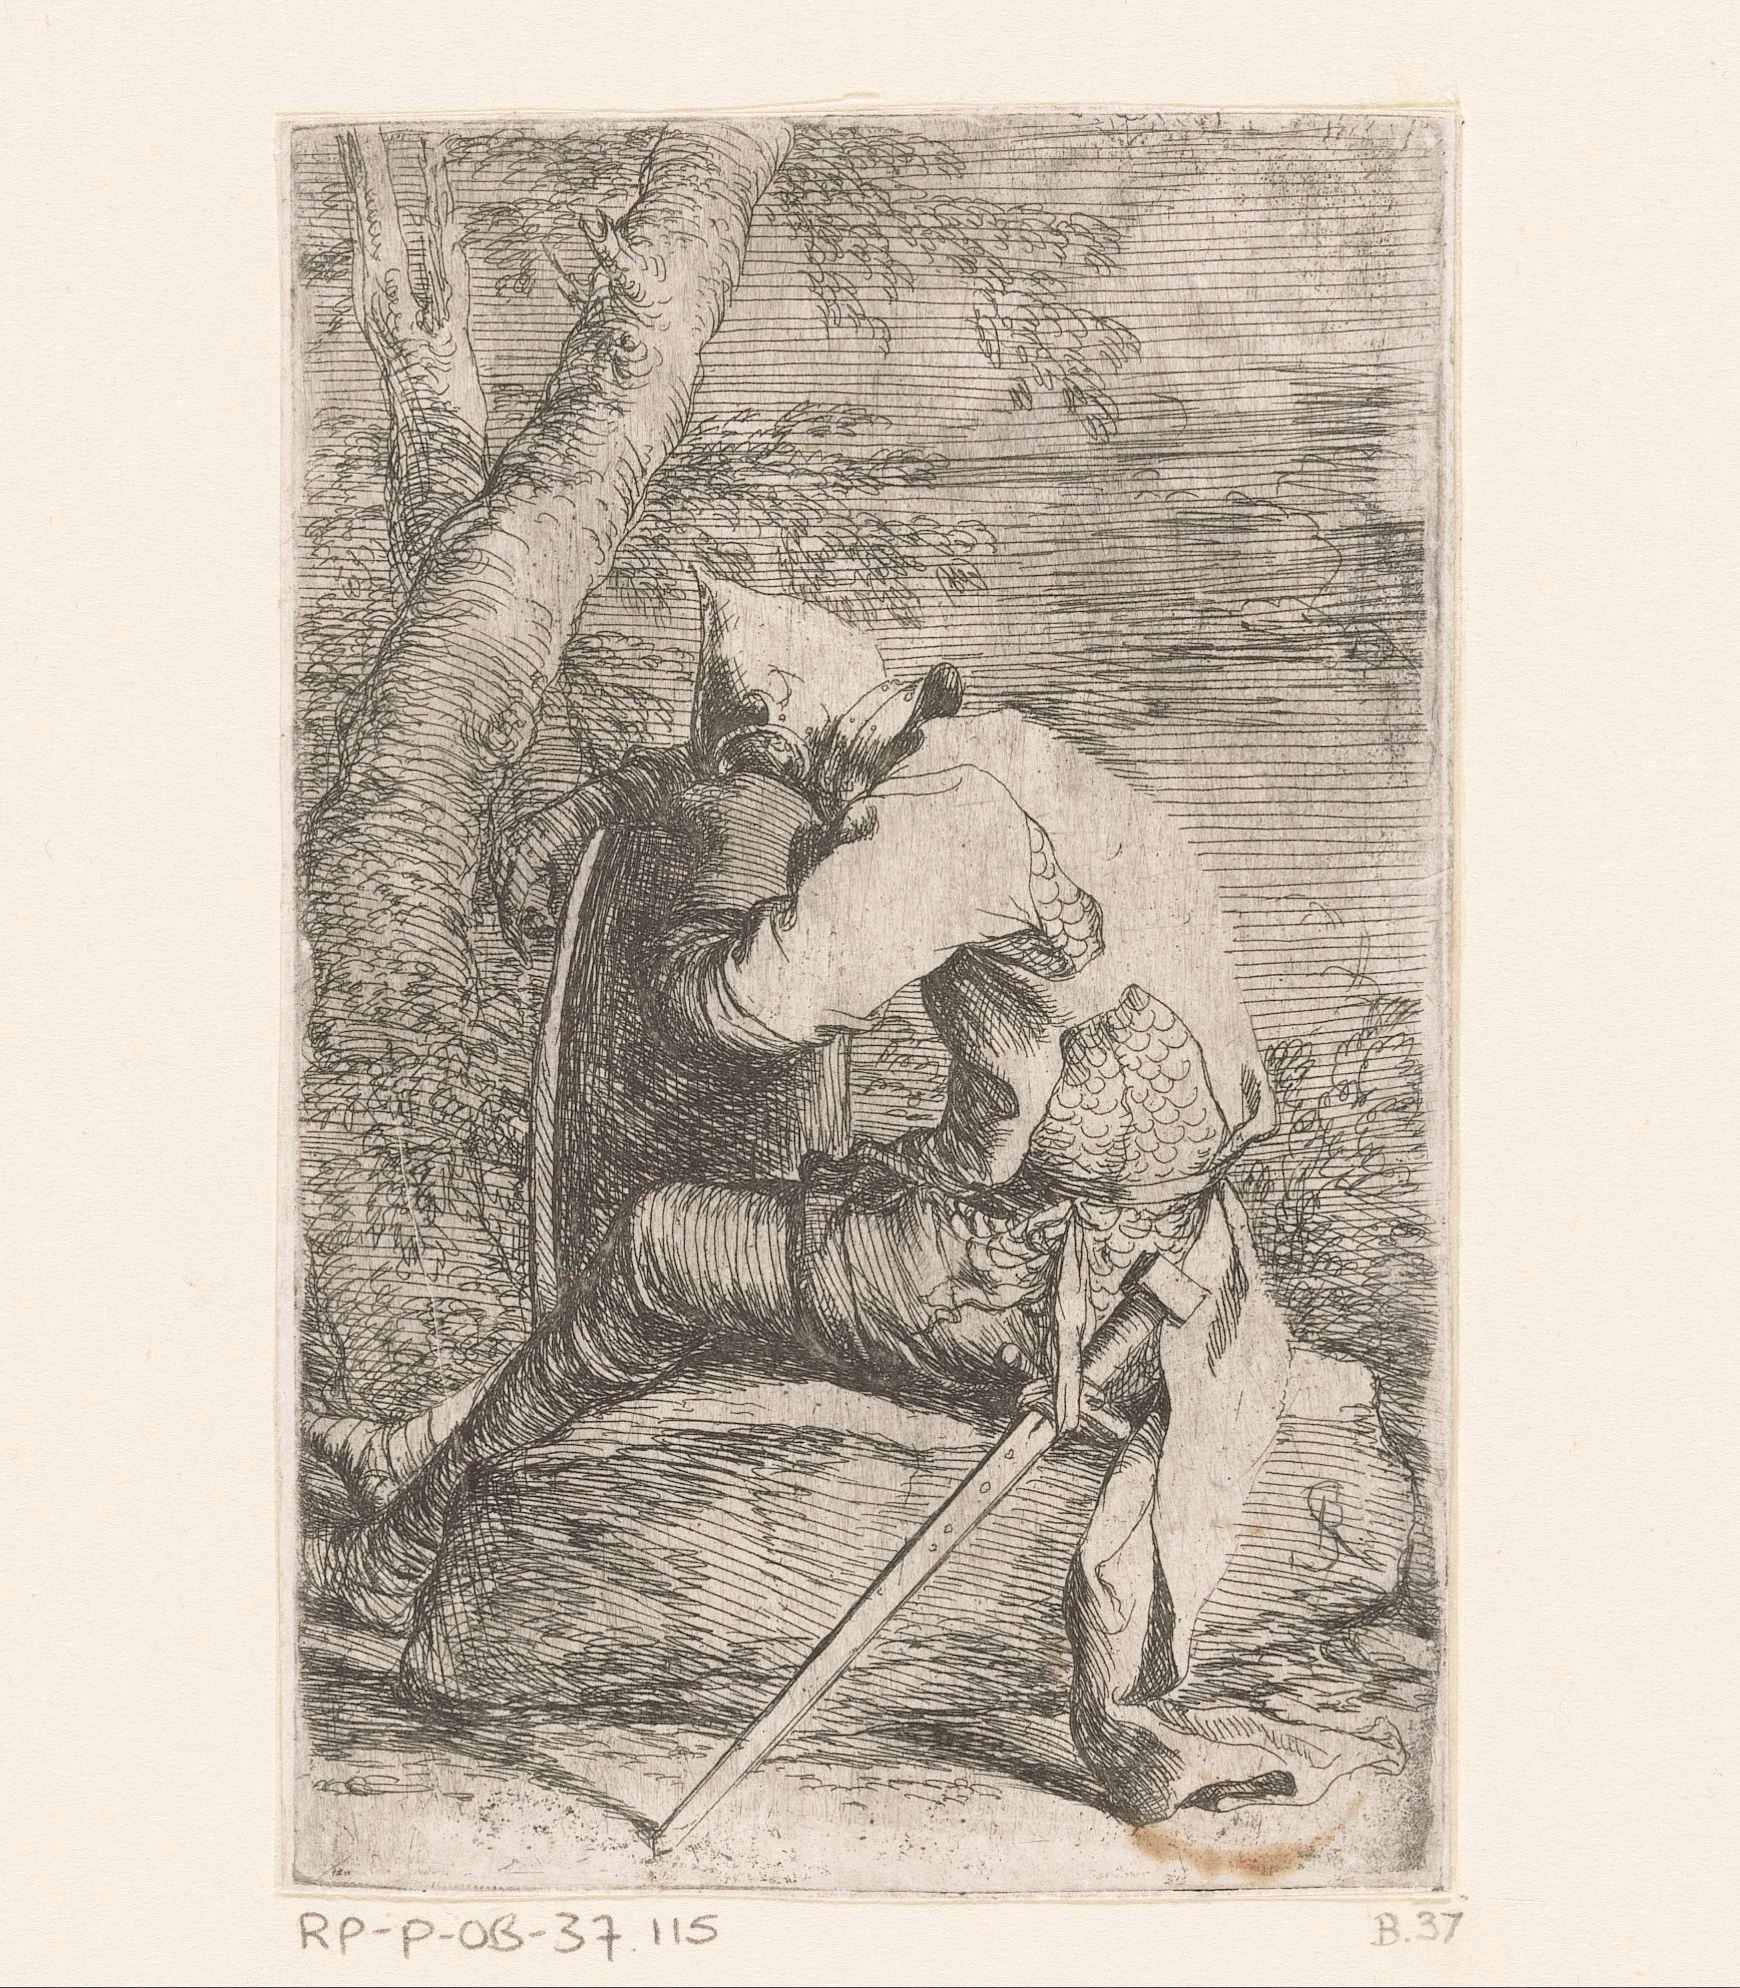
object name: print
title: Zittende soldaat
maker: salvator rosa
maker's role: draughtsman, painter, print maker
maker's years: 1615-1673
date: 1656-1657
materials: paper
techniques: drypoint, etching, intaglio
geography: italy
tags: protective weapons: shield, hacking and thrusting weapons: sword, the soldier; the soldier's life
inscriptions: collector's mark: Lugt 240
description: Deze prent maakt deel uit van de serie 'Figurine', bestaande uit een titelprent en 80 prenten van klein formaat met voorstellingen van mannelijke en vrouwelijke figuren. Rosa produceerde de serie waarschijnlijk gedurende de jaren 1656 en 1657.